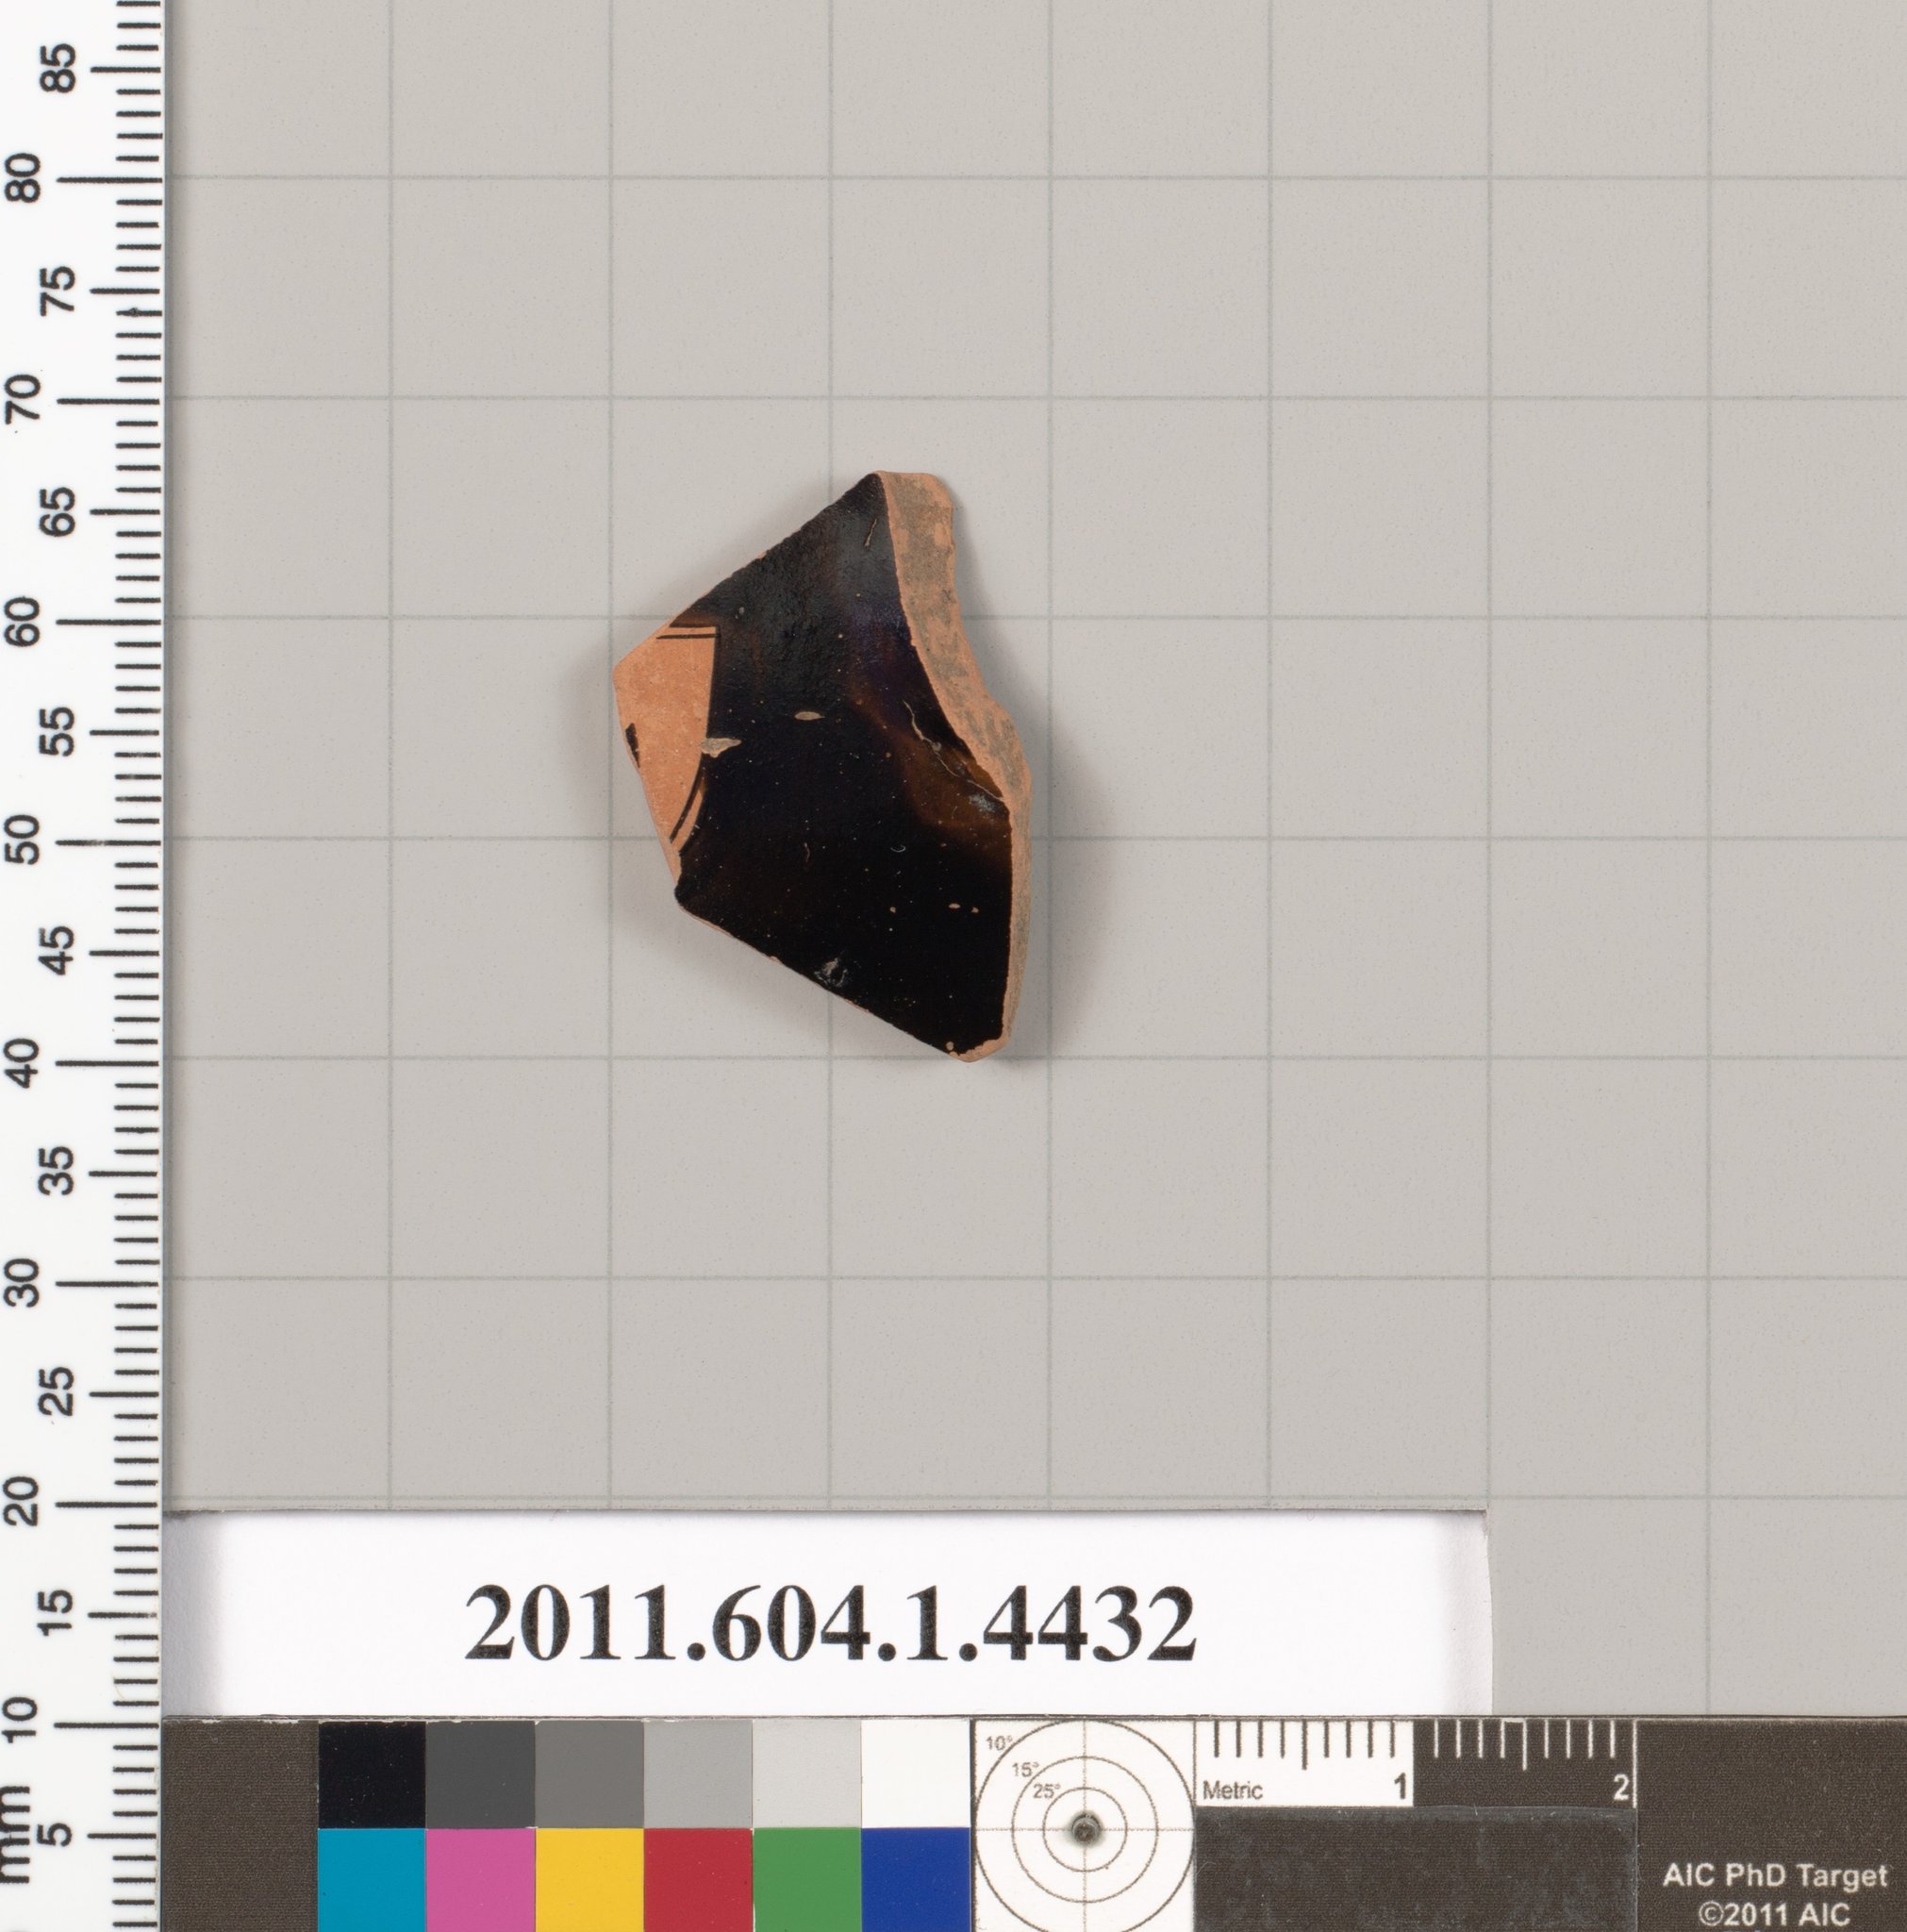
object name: kylix fragment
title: Terracotta fragment of a kylix (drinking cup)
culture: greek, attic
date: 490-470 BCE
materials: terracotta